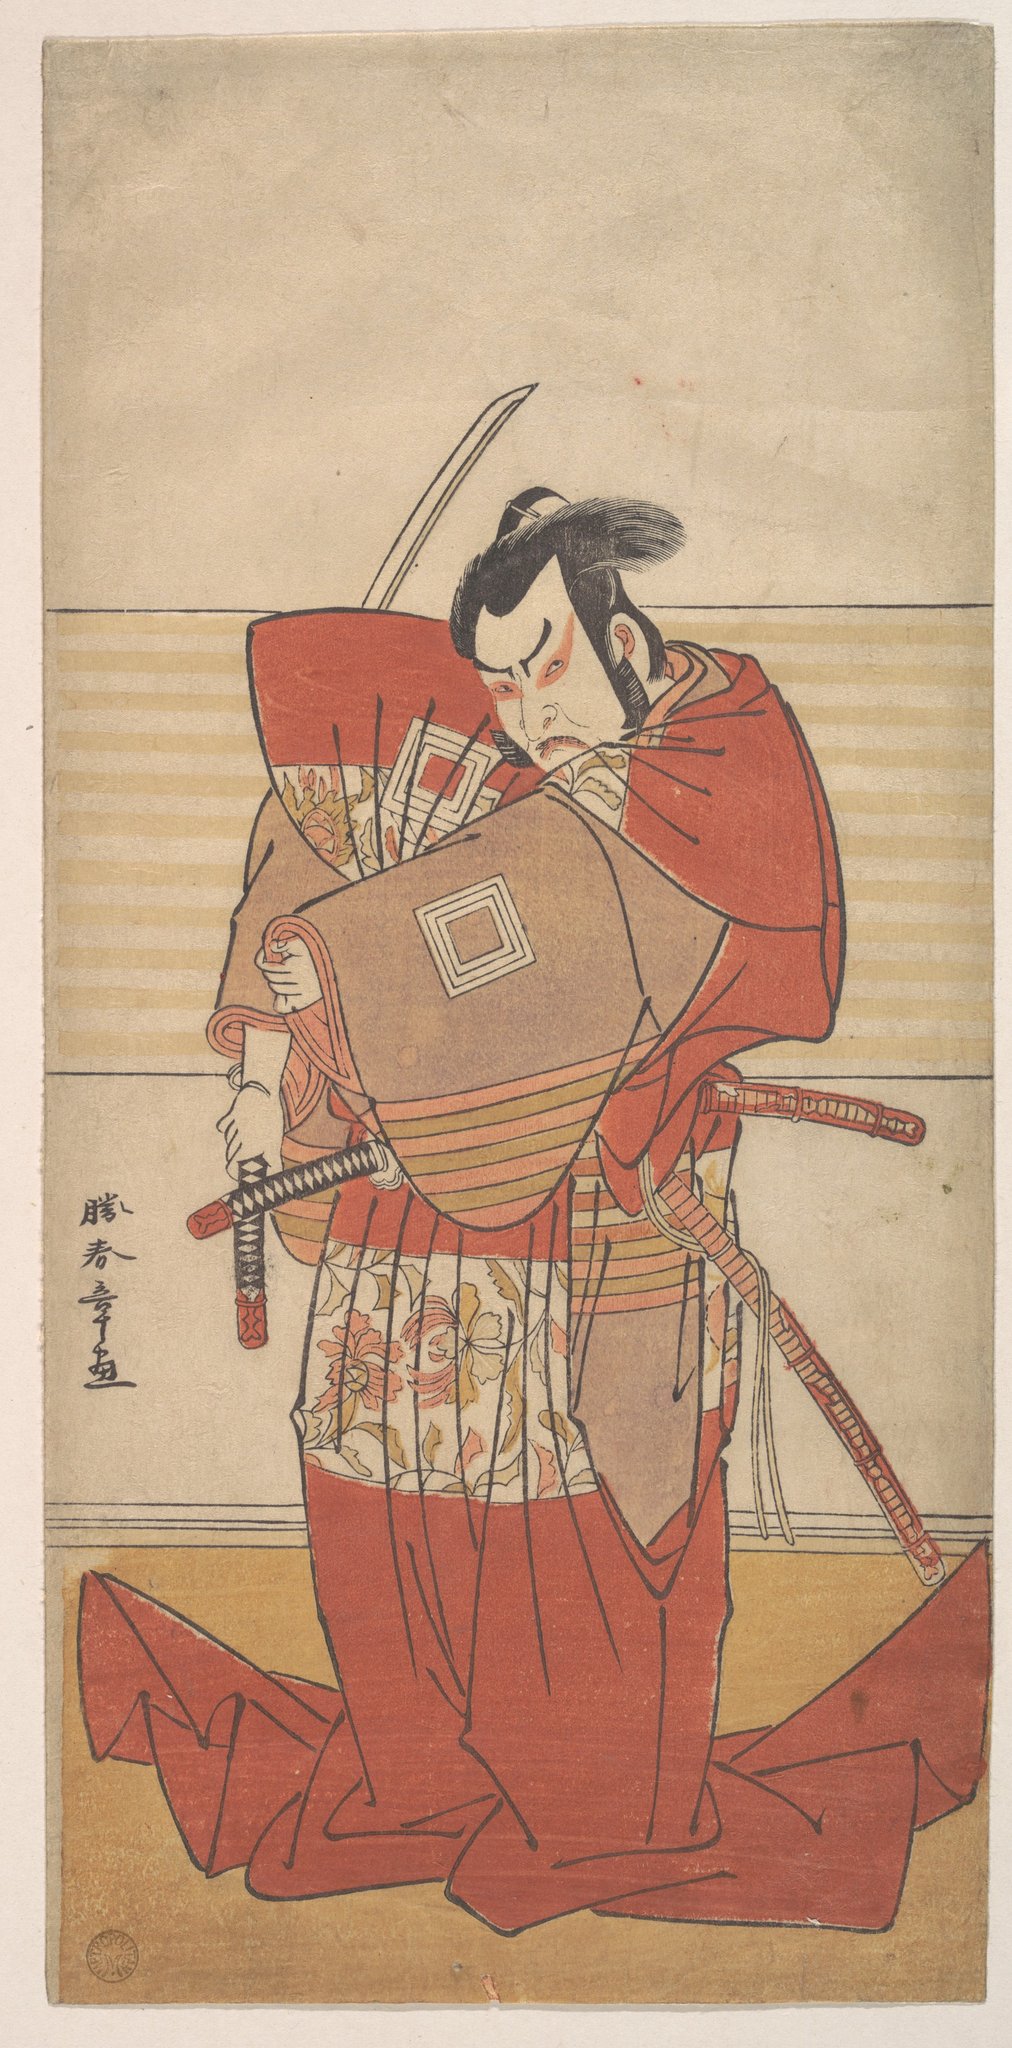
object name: woodblock print nishiki e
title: The Actor Ishikawa Danjuro V Performing a Shibaroku Act with a Drawn Sword in His Hand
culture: japanese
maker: katsukawa shunshō 勝川春章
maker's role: artist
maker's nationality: japanese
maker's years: 1726-1792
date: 1781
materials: ink, paper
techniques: nishiki e, woodblock print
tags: swords,men,actors